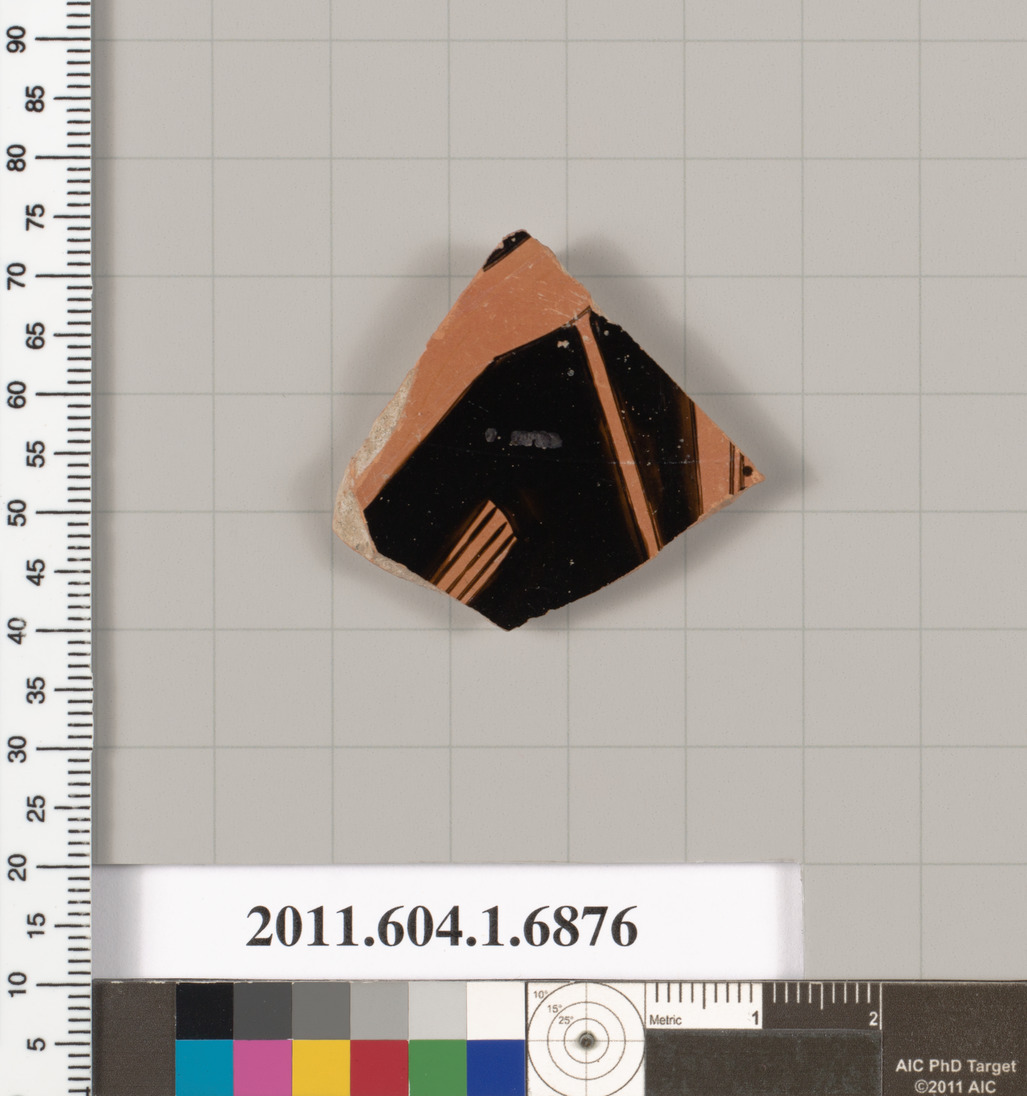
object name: kylix fragment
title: Terracotta fragment of a kylix (drinking cup)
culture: greek, attic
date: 490-470 BCE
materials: terracotta